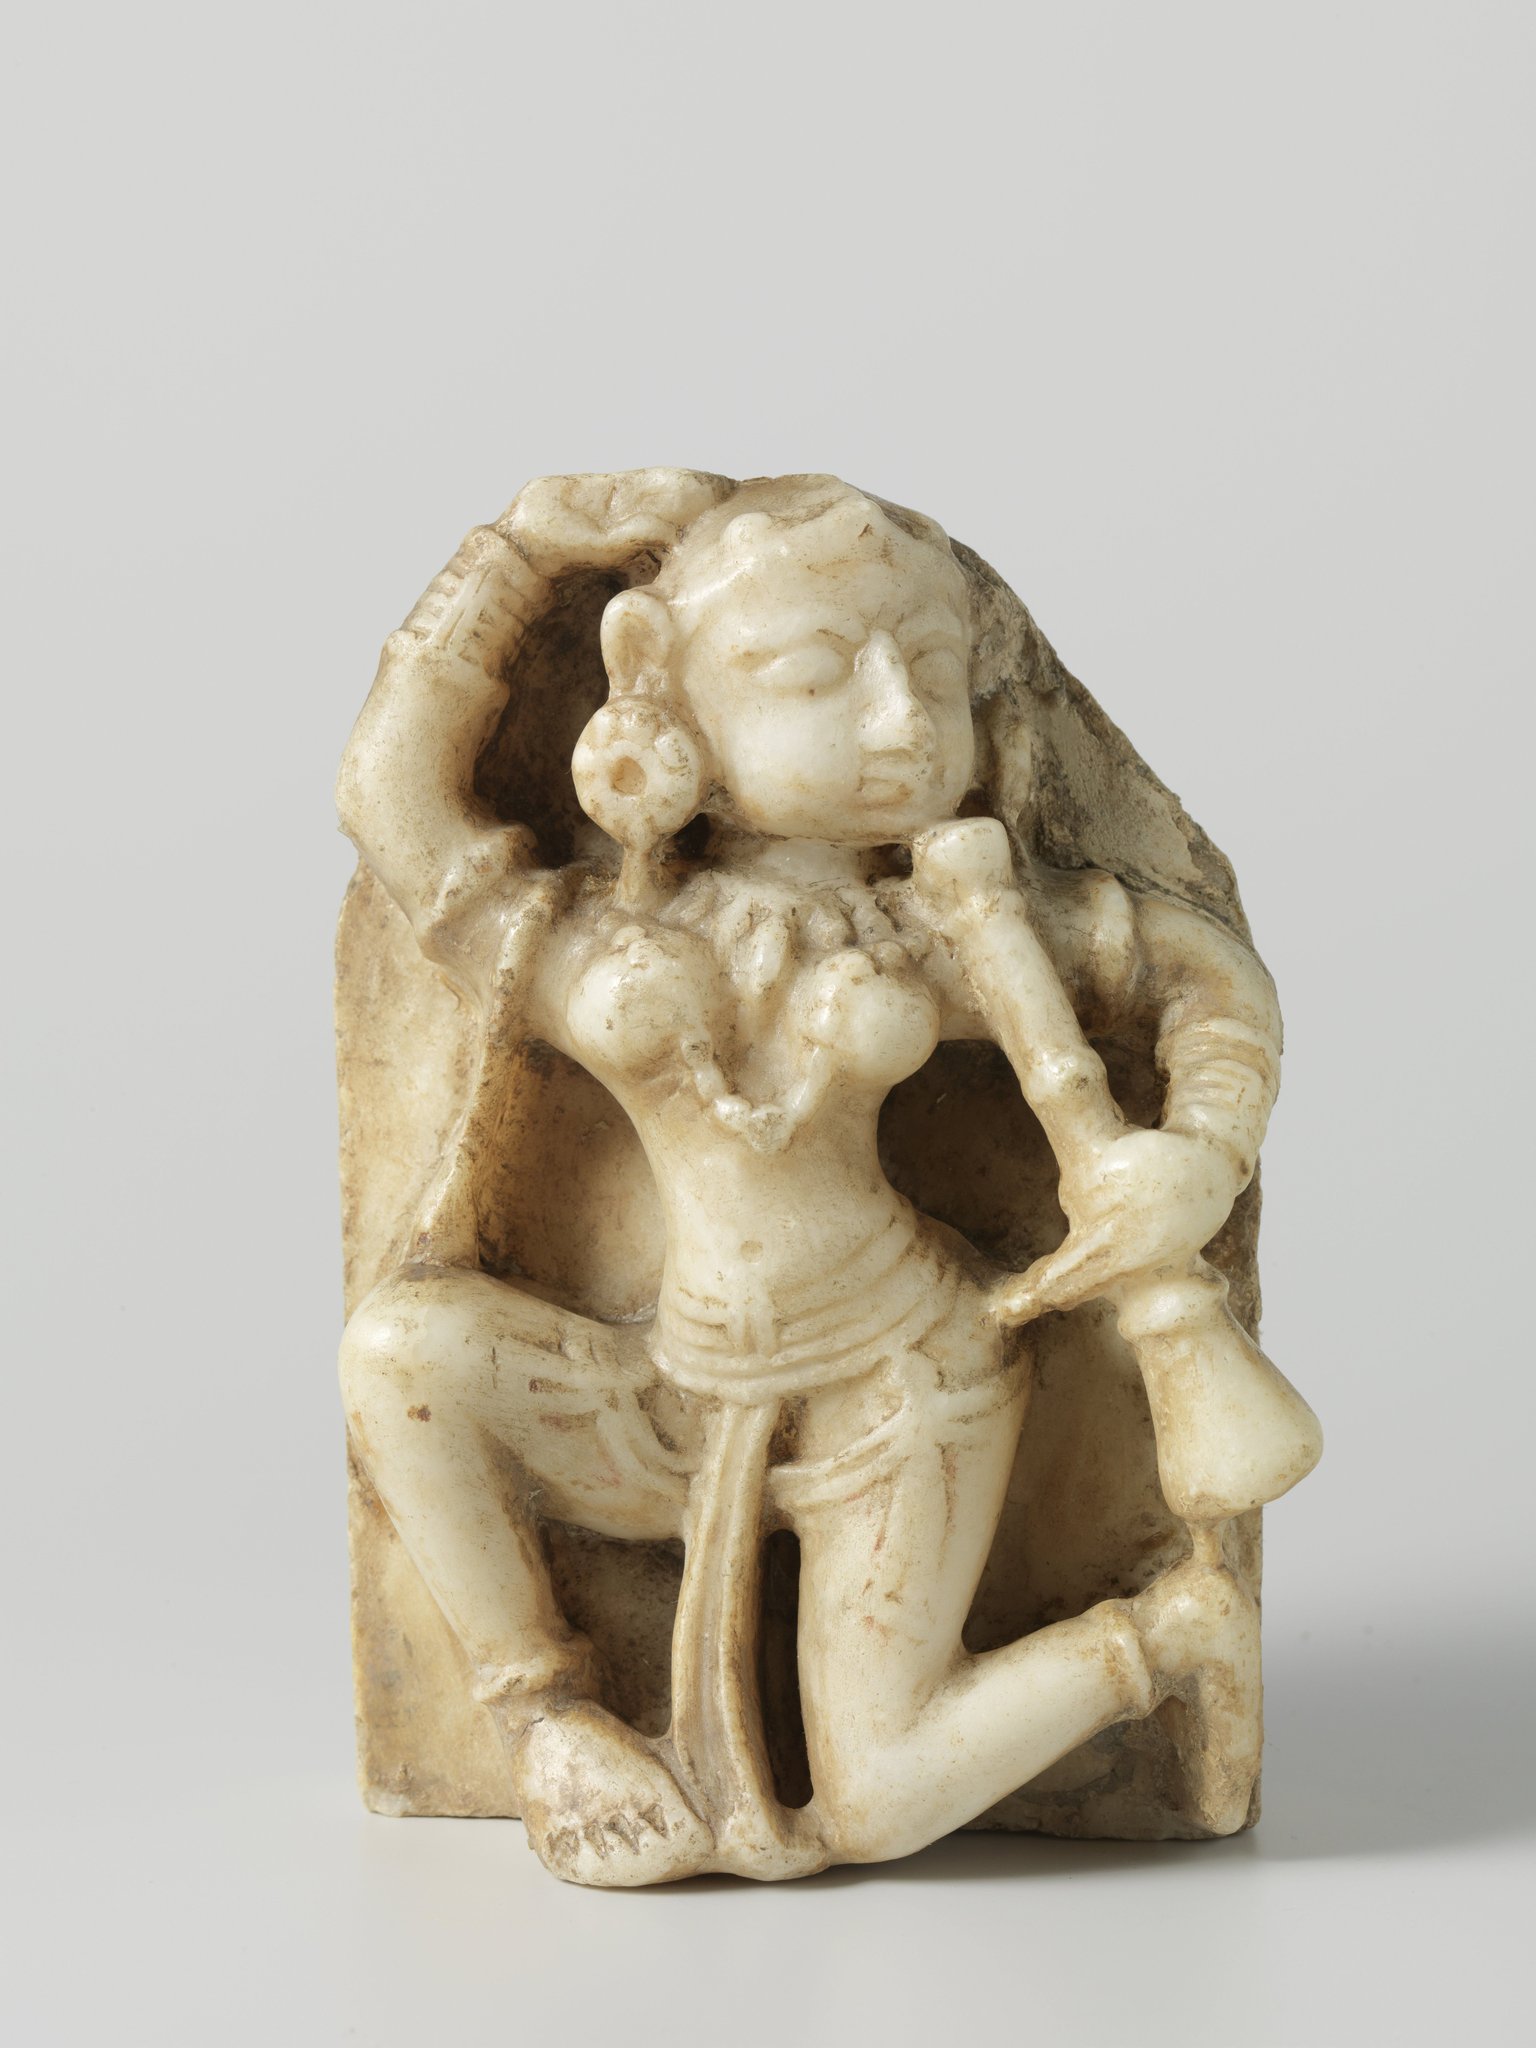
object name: fragment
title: Hemelnimf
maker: Anonymous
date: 1600-1699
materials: marble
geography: india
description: Hemelnimf die een blaasinstrument bespeelt.